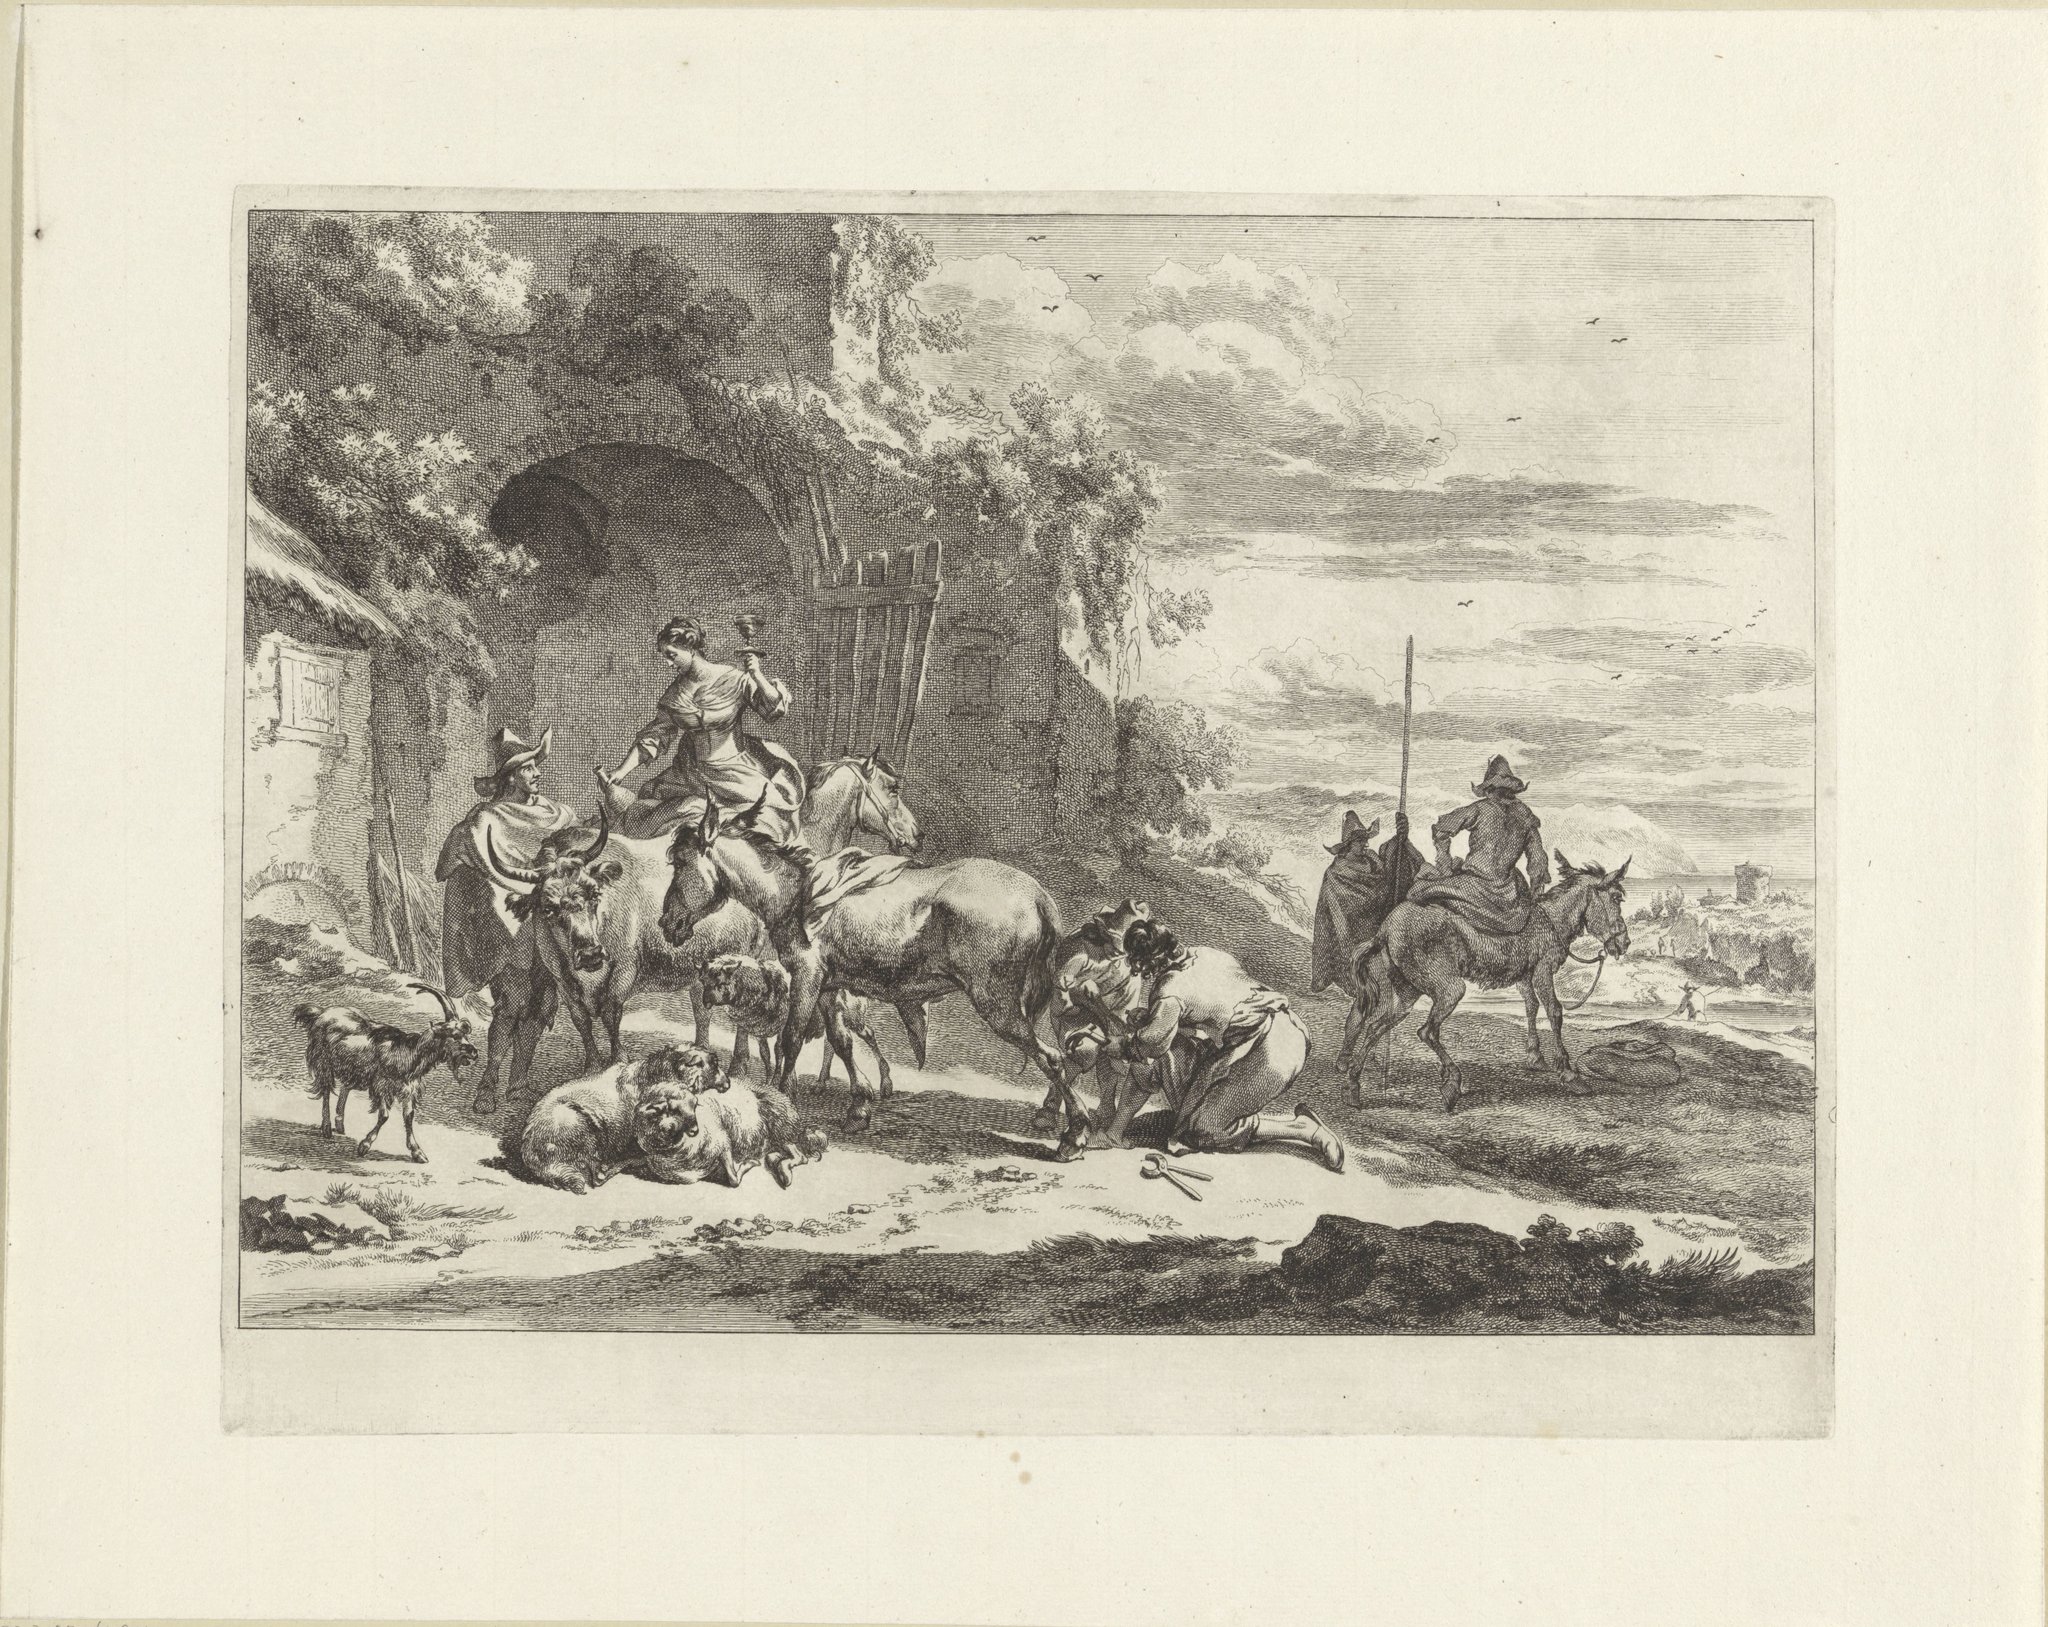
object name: print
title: Hoefsmid beslaat een ezel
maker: jan de visscher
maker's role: print maker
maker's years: 1633-1712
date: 1643-1692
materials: paper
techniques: engraving, etching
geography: northern netherlands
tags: cow, landscapes, farrier, shoeing-smith, ass, donkey, herding, herdsman, herdswoman, shepherd, shepherdess, cowherd, etc.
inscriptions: collector's mark: Lugt 240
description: In een bergachtig landschap voor een met planten begroeid gebouw beslaat een hoefsmid een ezel. Voor de ezel staan een koe en een paard. Op het paard zit een dame met een glas wijn.